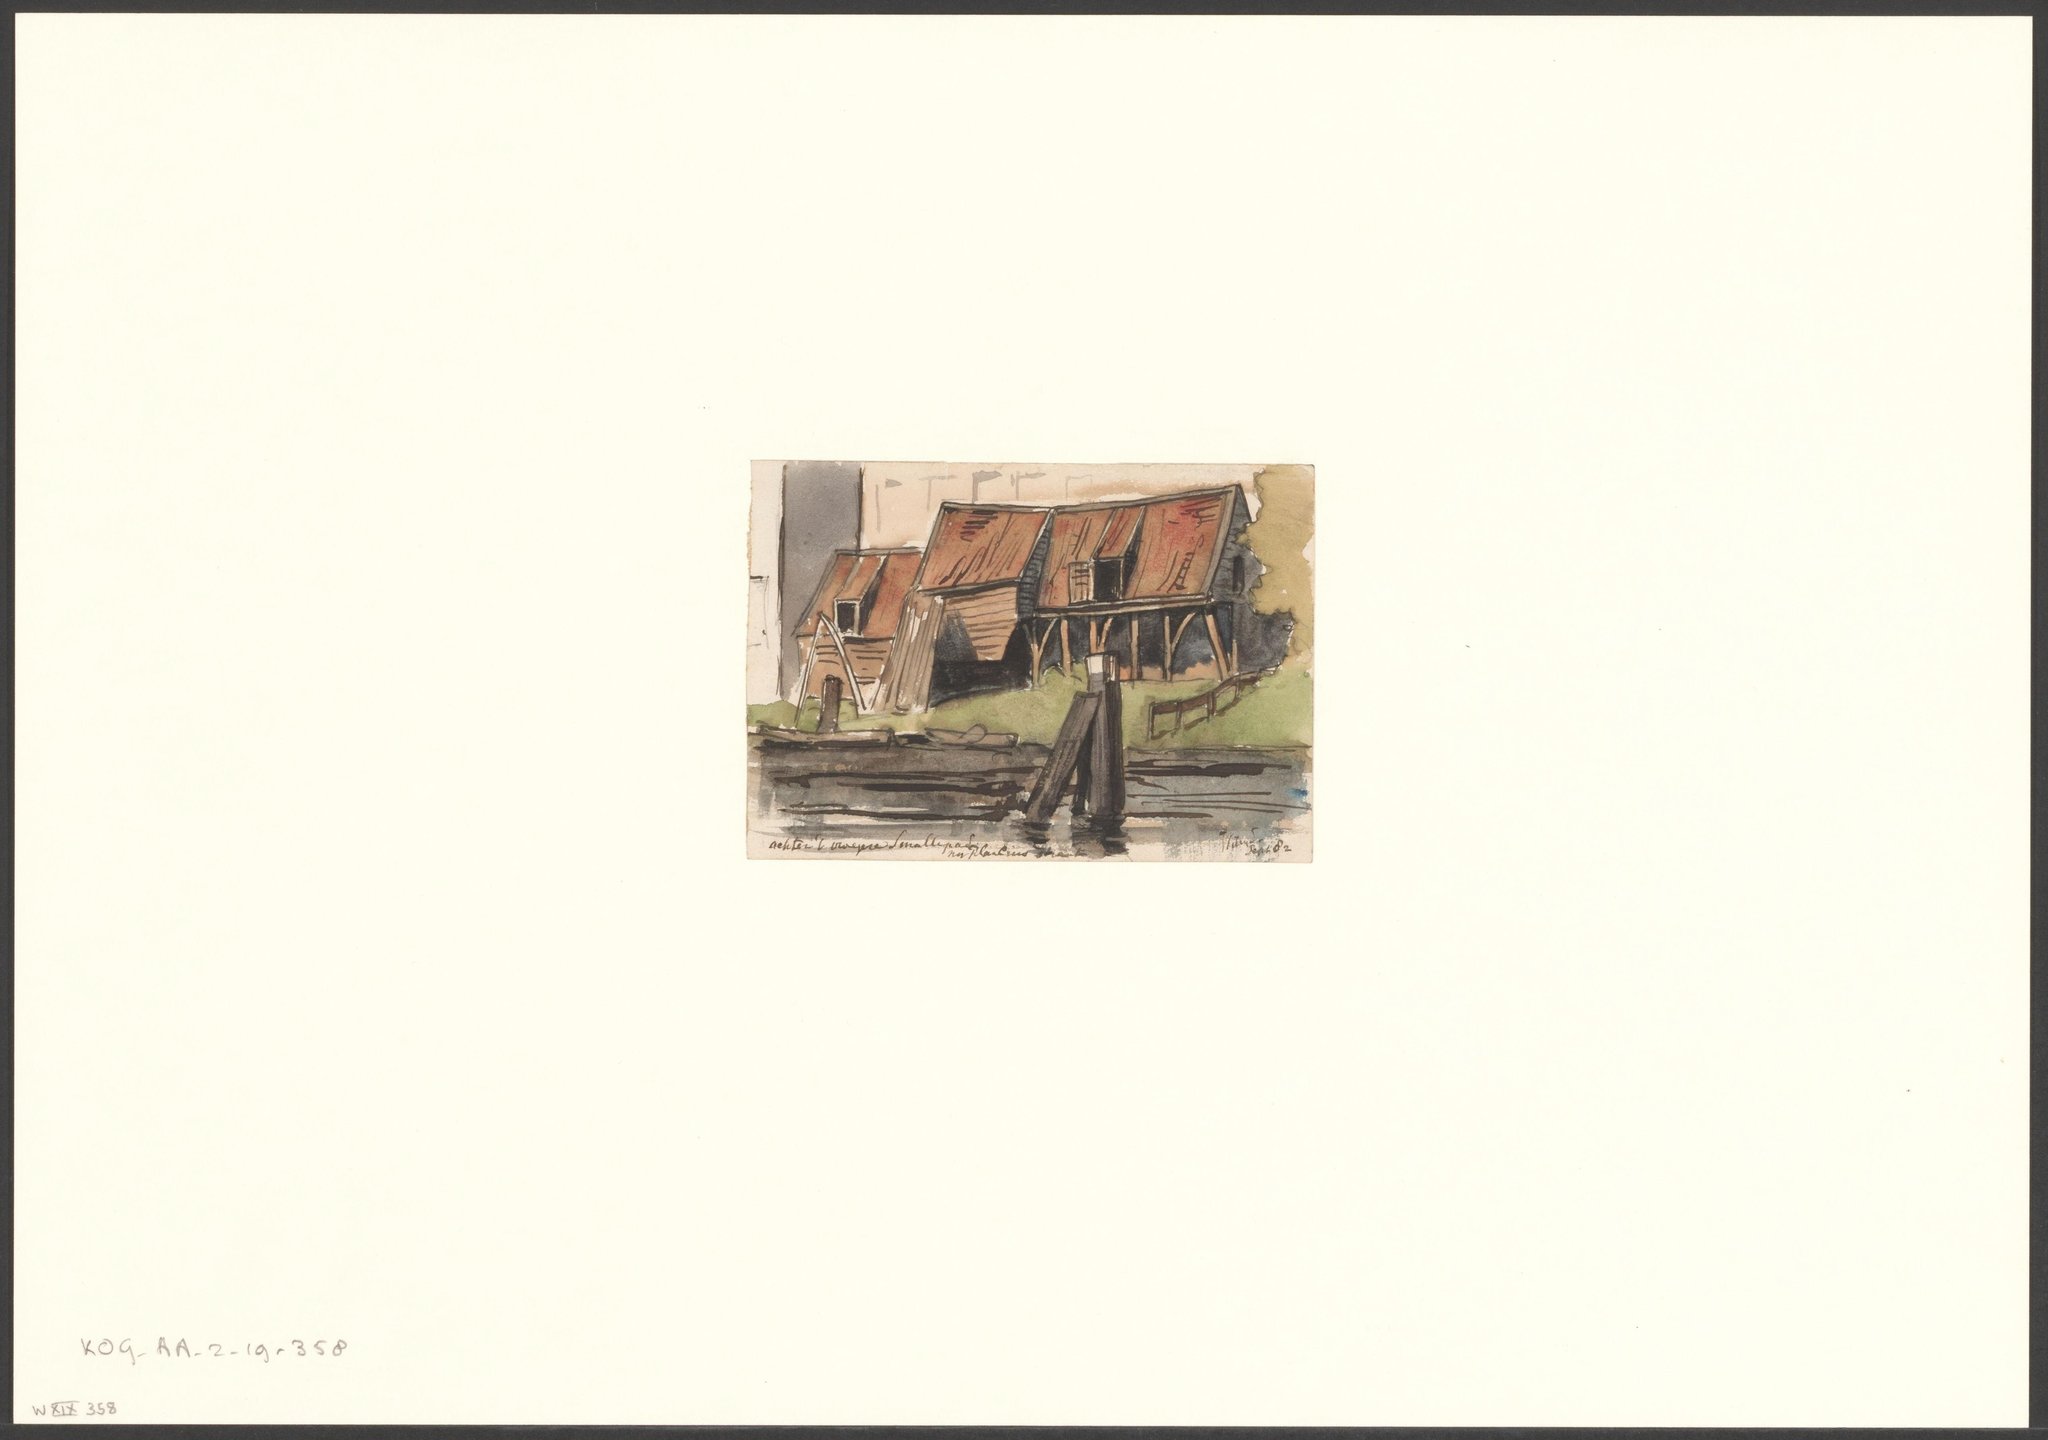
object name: drawing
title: Gezicht op de werf bij de Smallepadsgracht op het Prinseneiland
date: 1809-1882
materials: ink, paper, watercolor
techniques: brush, pen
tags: city-view in general; 'veduta', pier, quay, wharf, façade (of house or building)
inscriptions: inscription: ‘achter 't vroegere Smallepad / nu Plancius straat’, signature and date: ‘WillemS. / sept 82’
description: Tekening binnen de Atlas Van Eck ingedeeld op wijknummer 19.